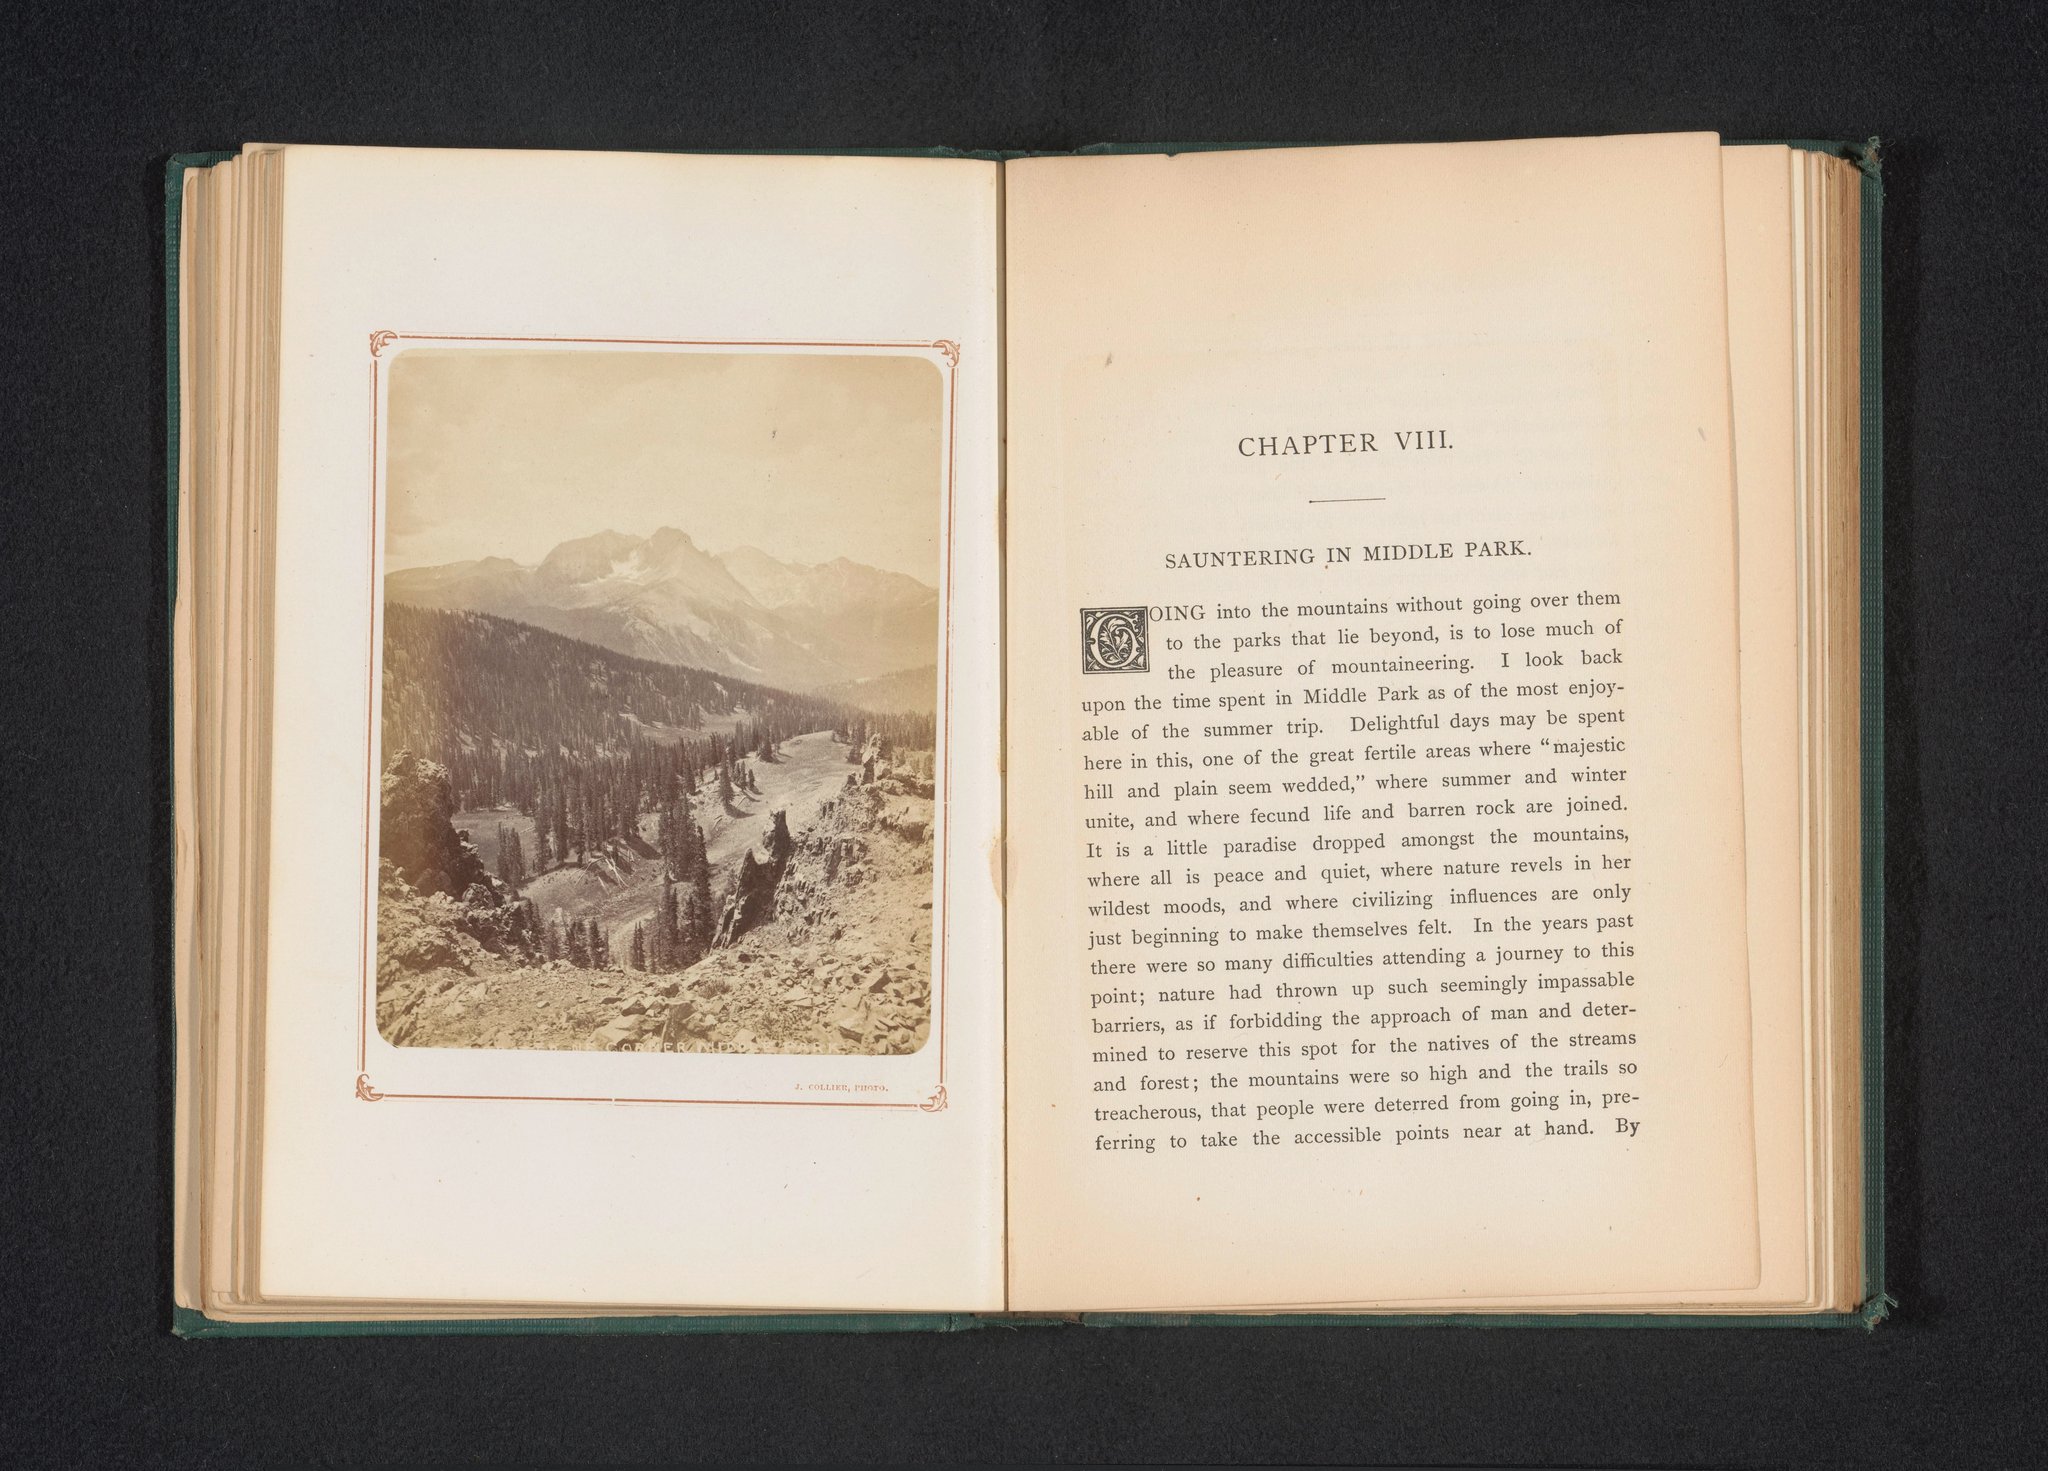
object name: photograph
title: N.E. Corner Middle Park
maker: joseph collier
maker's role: fotograaf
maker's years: 1836-1910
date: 1869-1874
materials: photographic support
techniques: albumen print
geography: colorado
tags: landscapes, mountains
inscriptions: inscription: ‘N.E. Corner Middle Park’